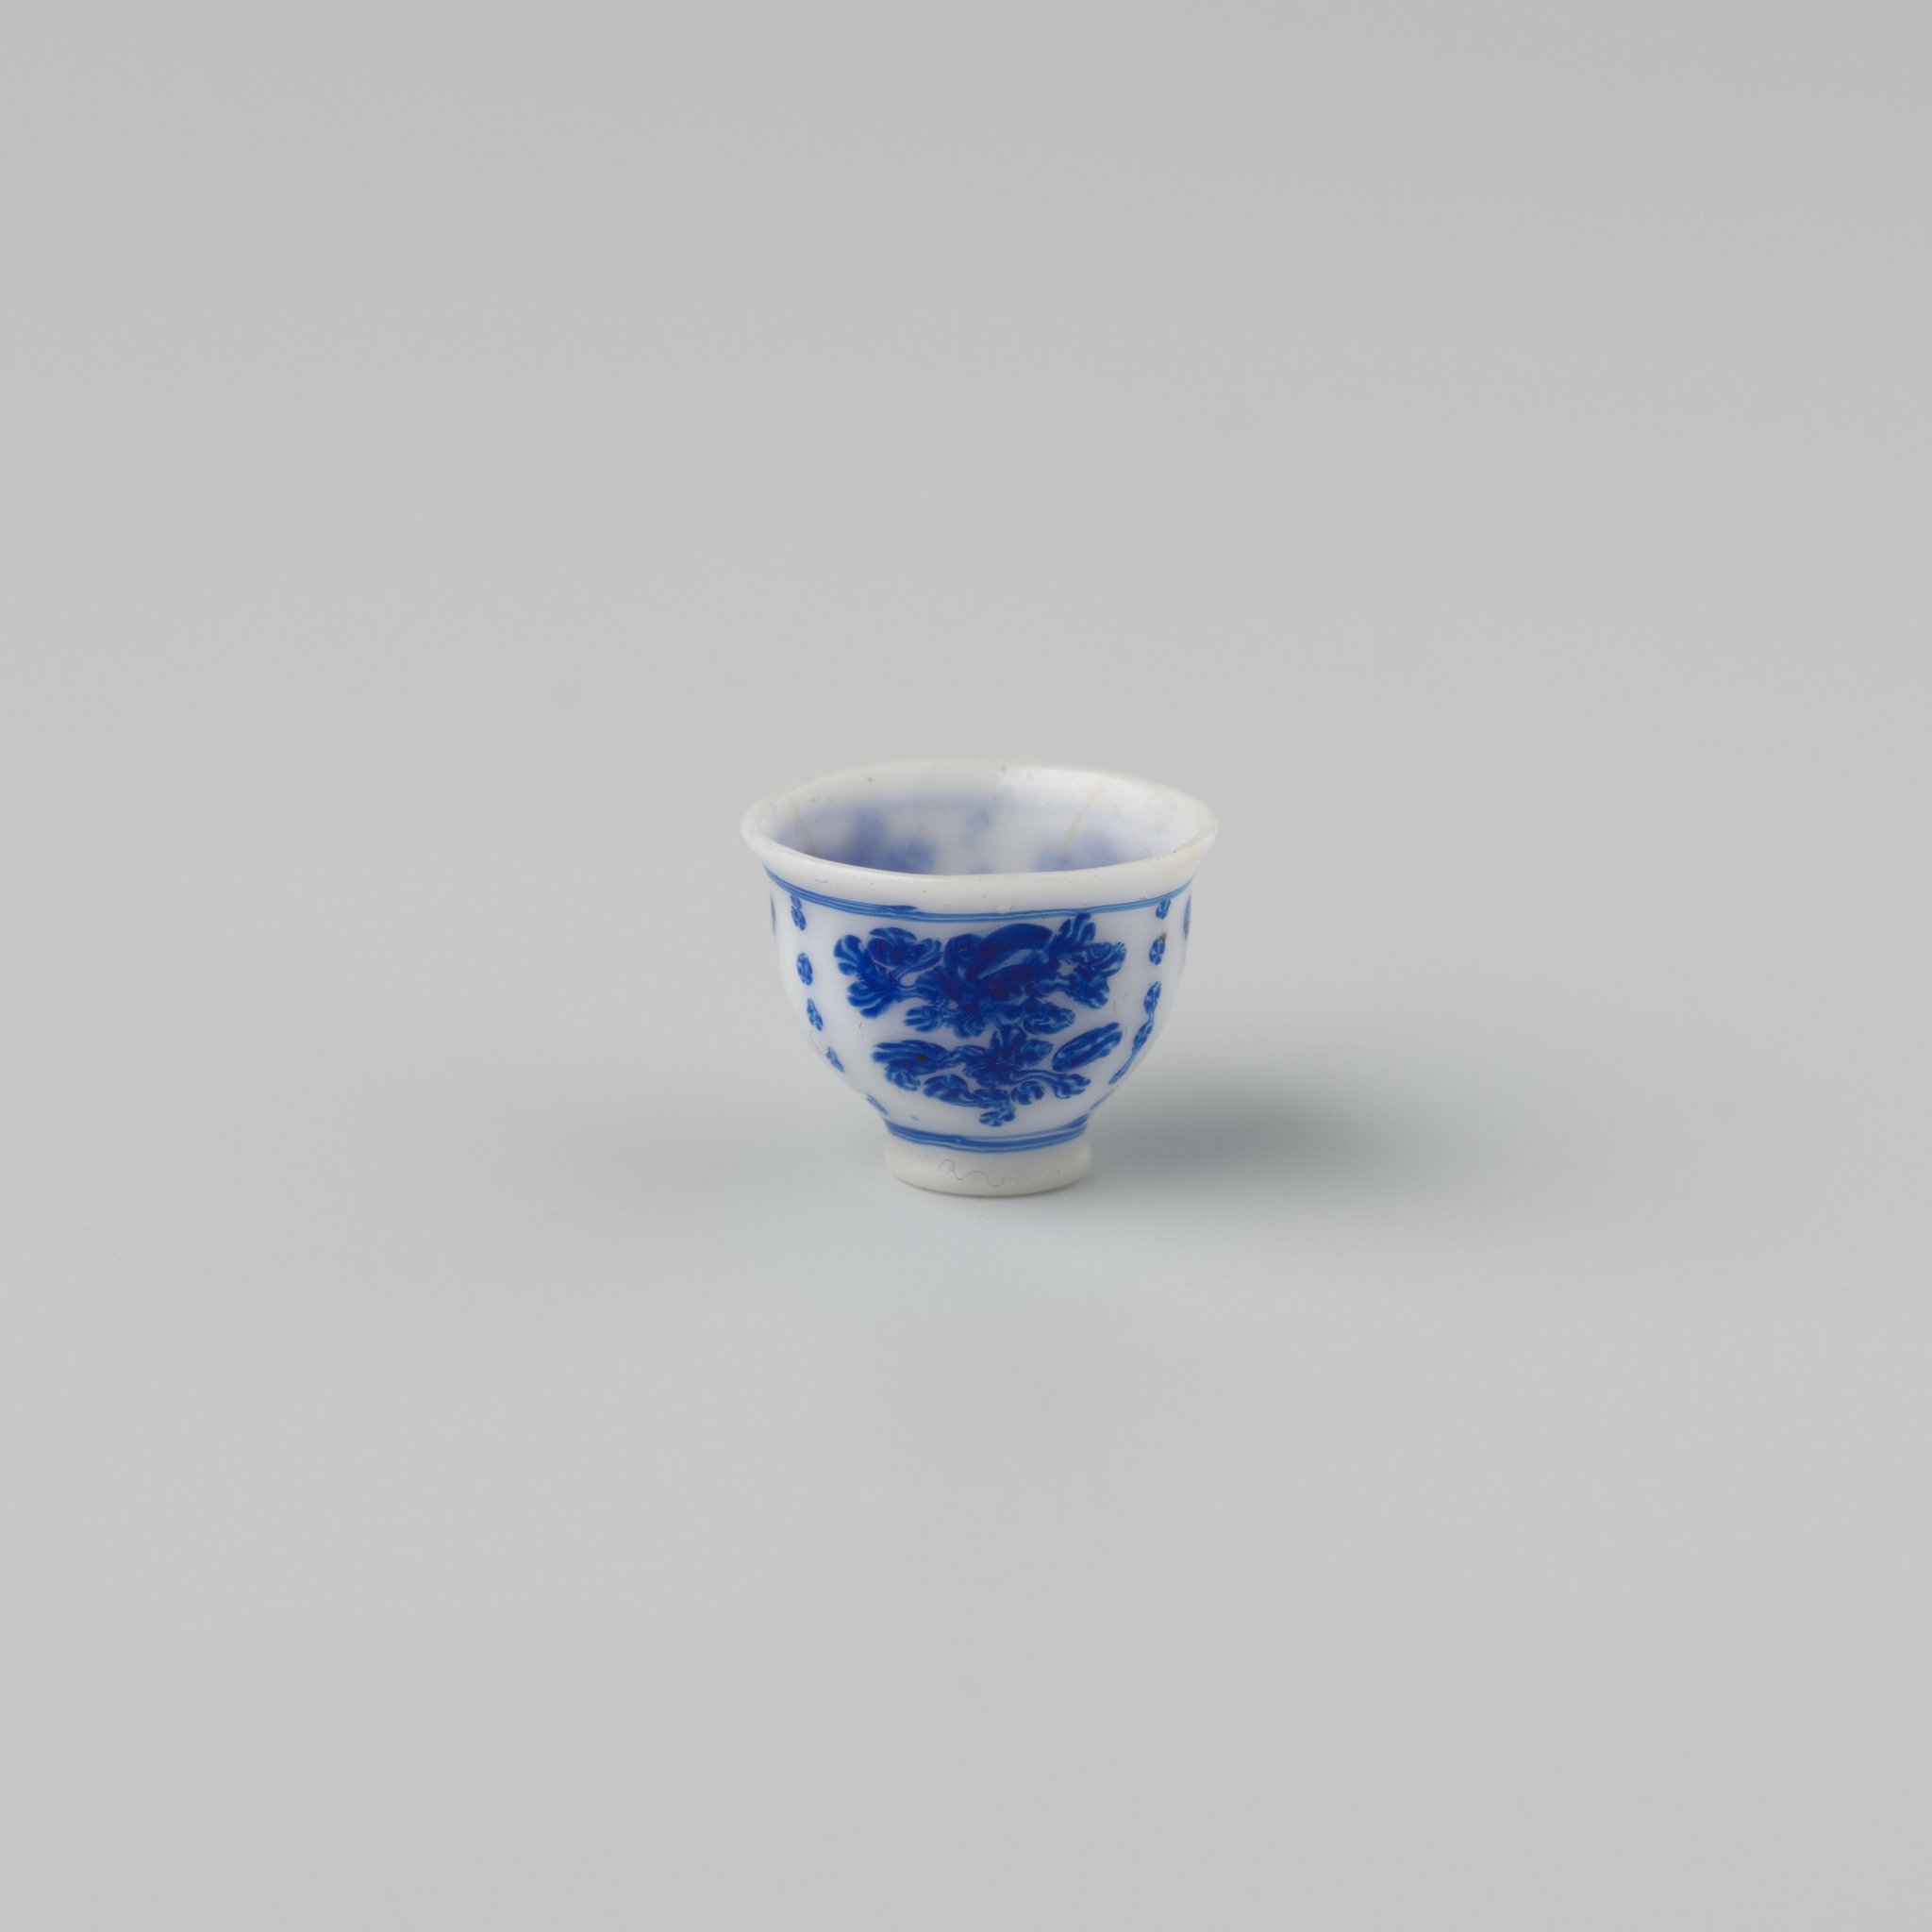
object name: tea cup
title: Theekopje van melkglas met blauwe emailverf beschildering, imitatie Chinees porselein met 'bloem' decoratie in vakken; op standring en met gladde mondrand.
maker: Anonymous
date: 1675-1710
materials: glass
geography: amsterdam